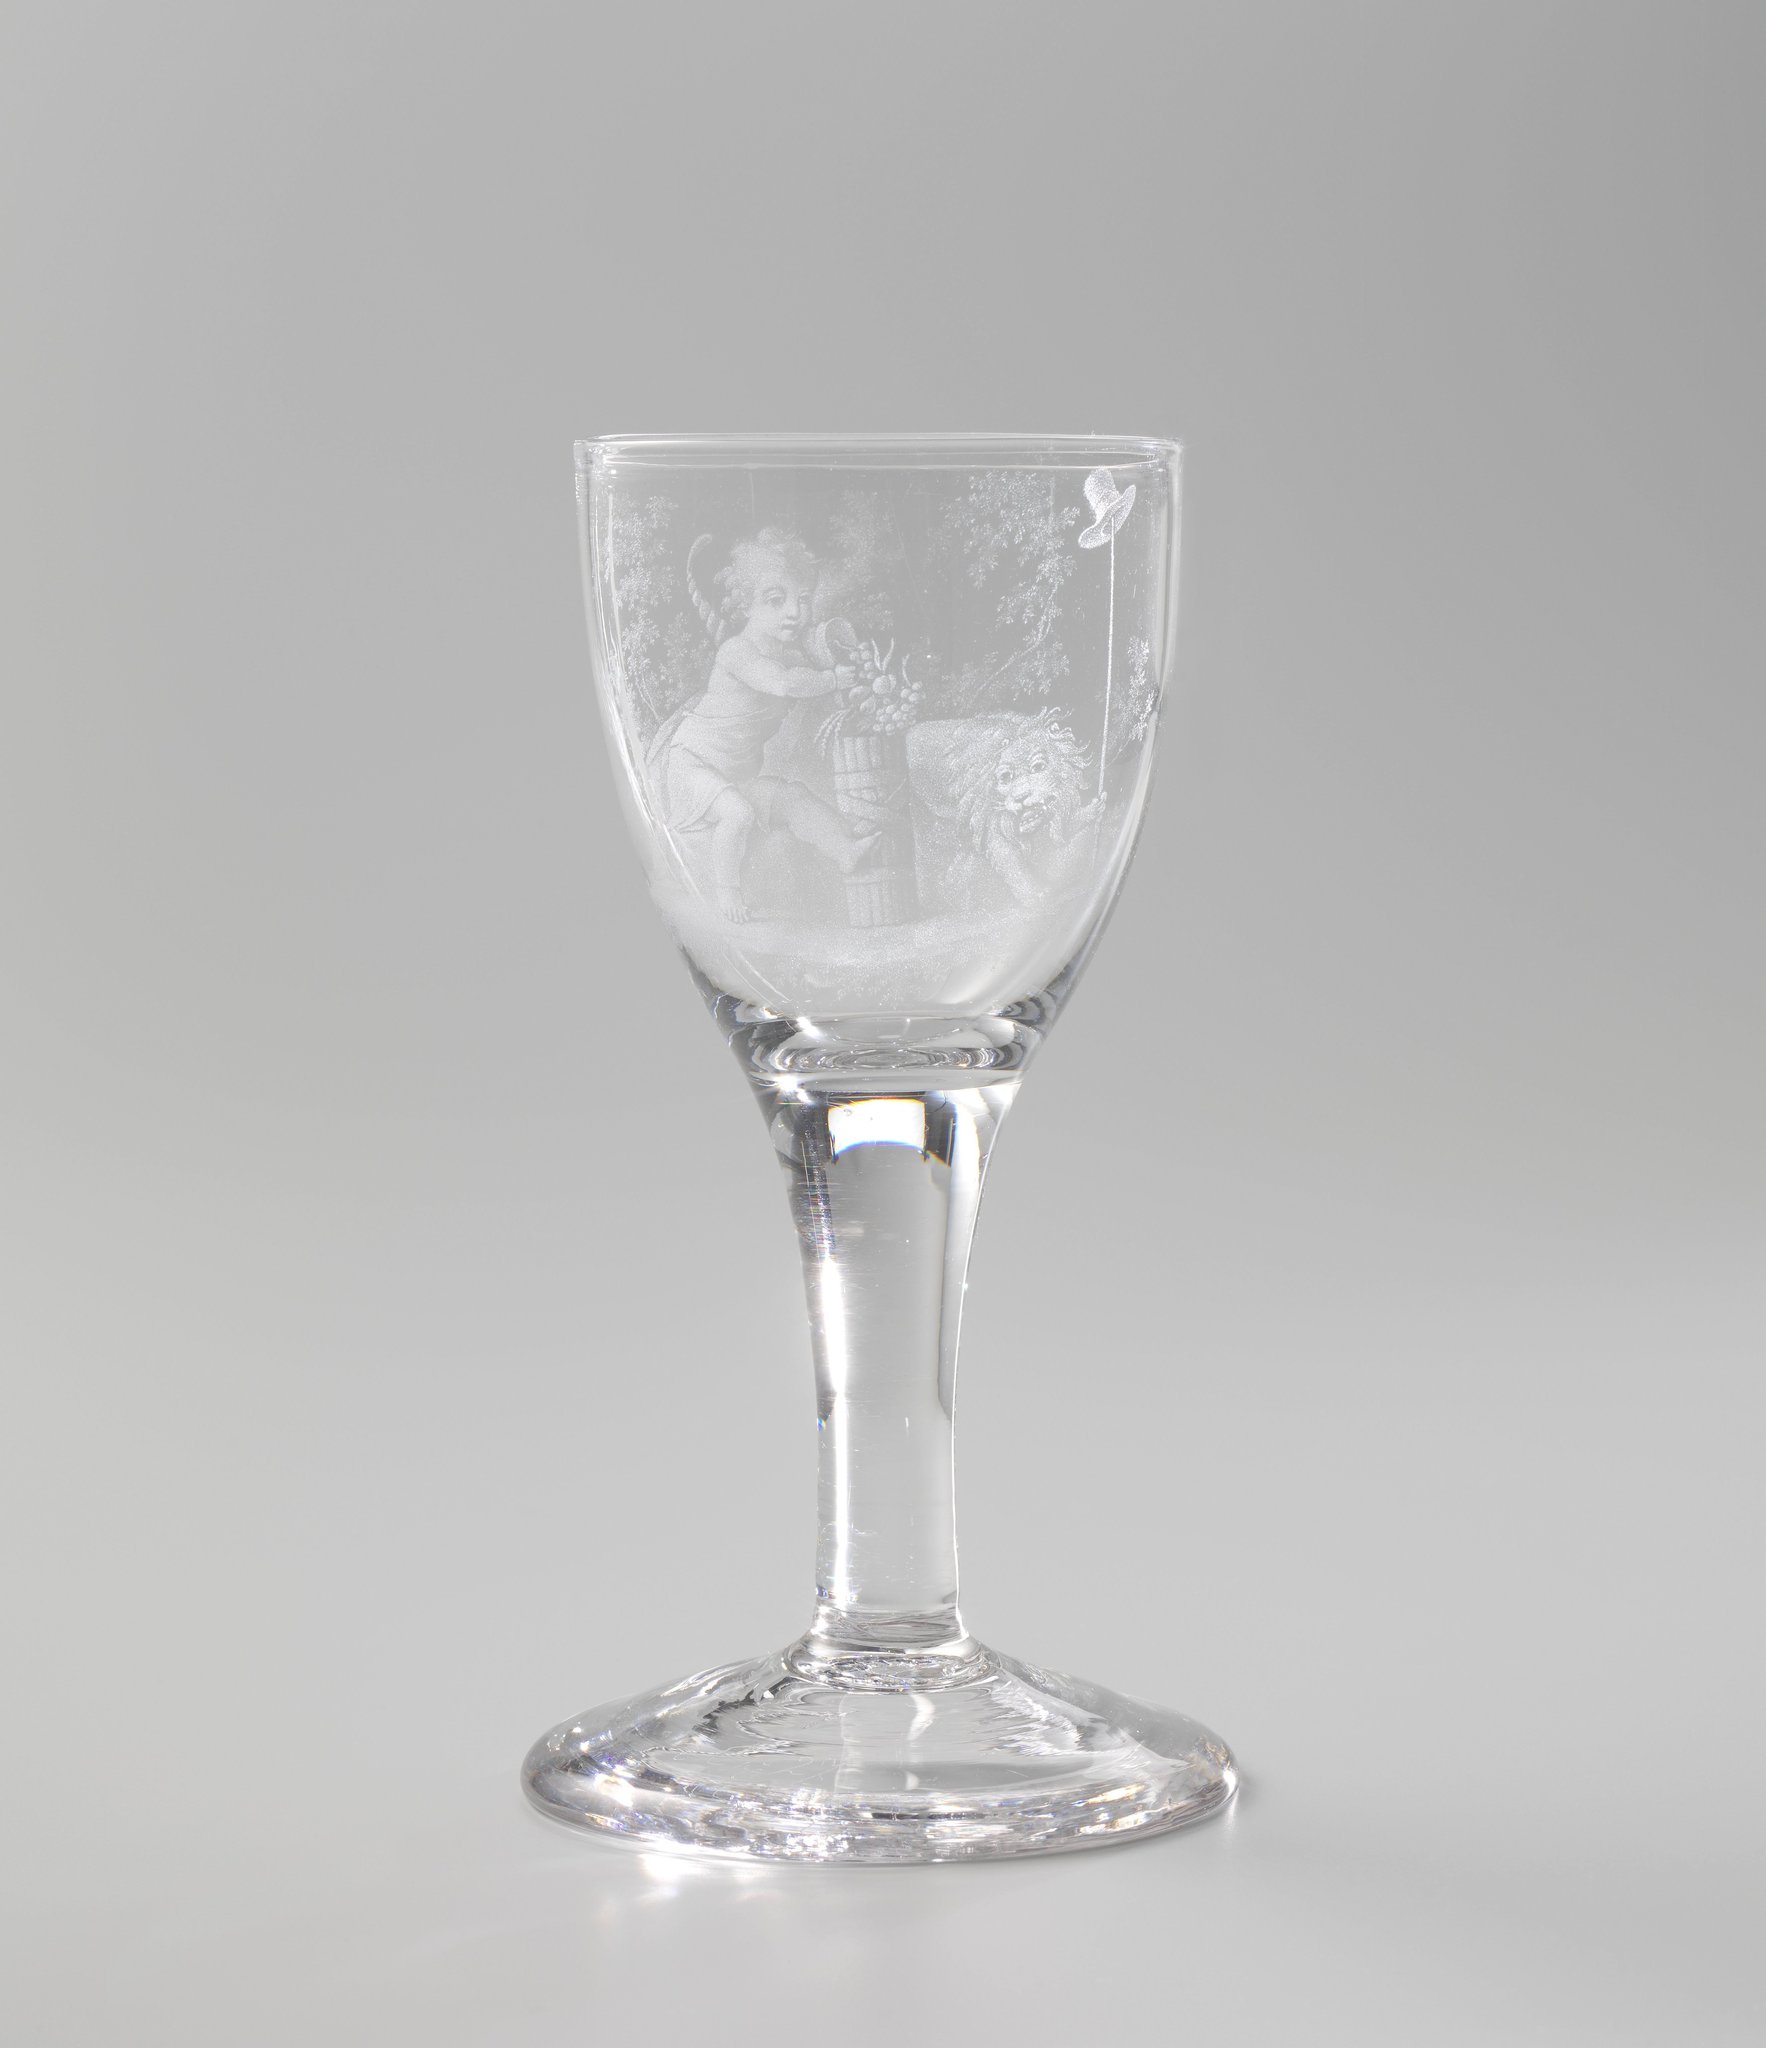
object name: goblet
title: Kelkglas met een voorstelling die mogelijk betrekking heeft op de welvaart die de alliantie met de Franse Republiek in 1795 bracht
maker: david wolff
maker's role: glasgraveur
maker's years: 1732-1798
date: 1795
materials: glass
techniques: glassblowing, engraving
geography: northern netherlands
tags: alliance with france (1795)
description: Conische voet. Gladde, zich verbredende stam, overgaande in een gebogen kelk. Op de kelk, in een landschap met bomen, zit een jongetje, dat een hoorn des overvloeds uitstort boven fasces, van waarachter de Bataafse Leeuw te voorschijn komt, met in de linkerklauw een lans met een vrijheidshoed.